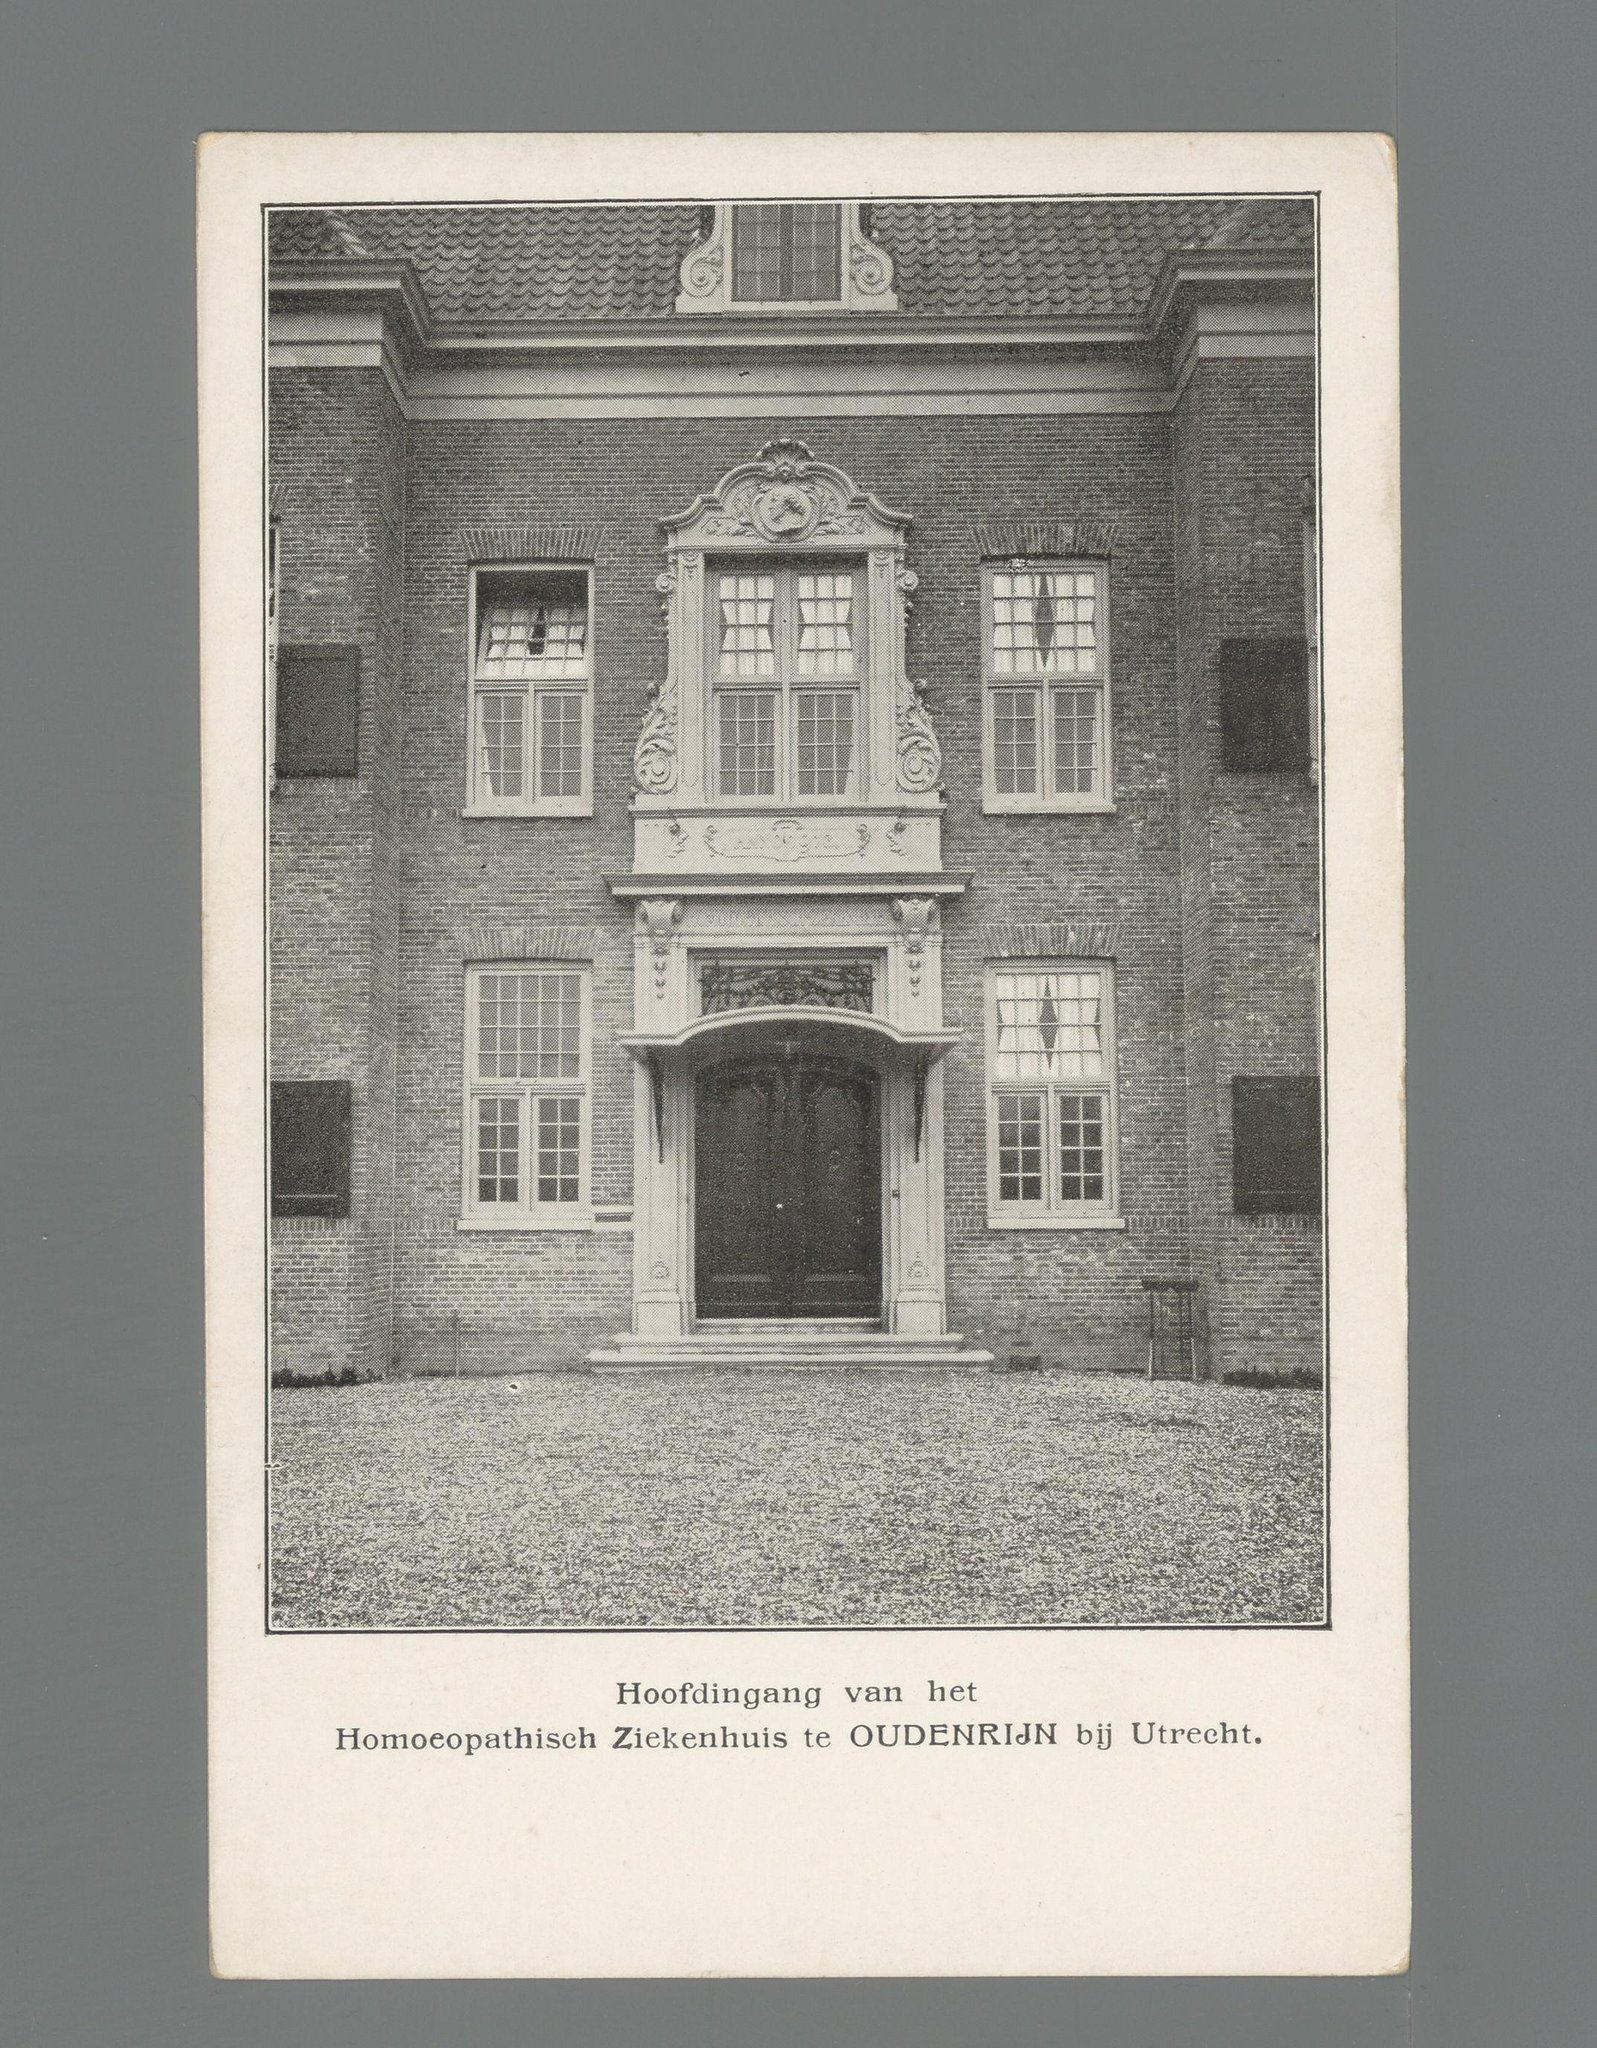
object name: ansichtkaart, prentbriefkaart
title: Hoofdingang van het Homoeopathisch Ziekenhuis te Oudenrijn bij Utrecht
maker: Anonymous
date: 1905-1930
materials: cardboard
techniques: autotype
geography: zwolle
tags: gate, entrance, hospital